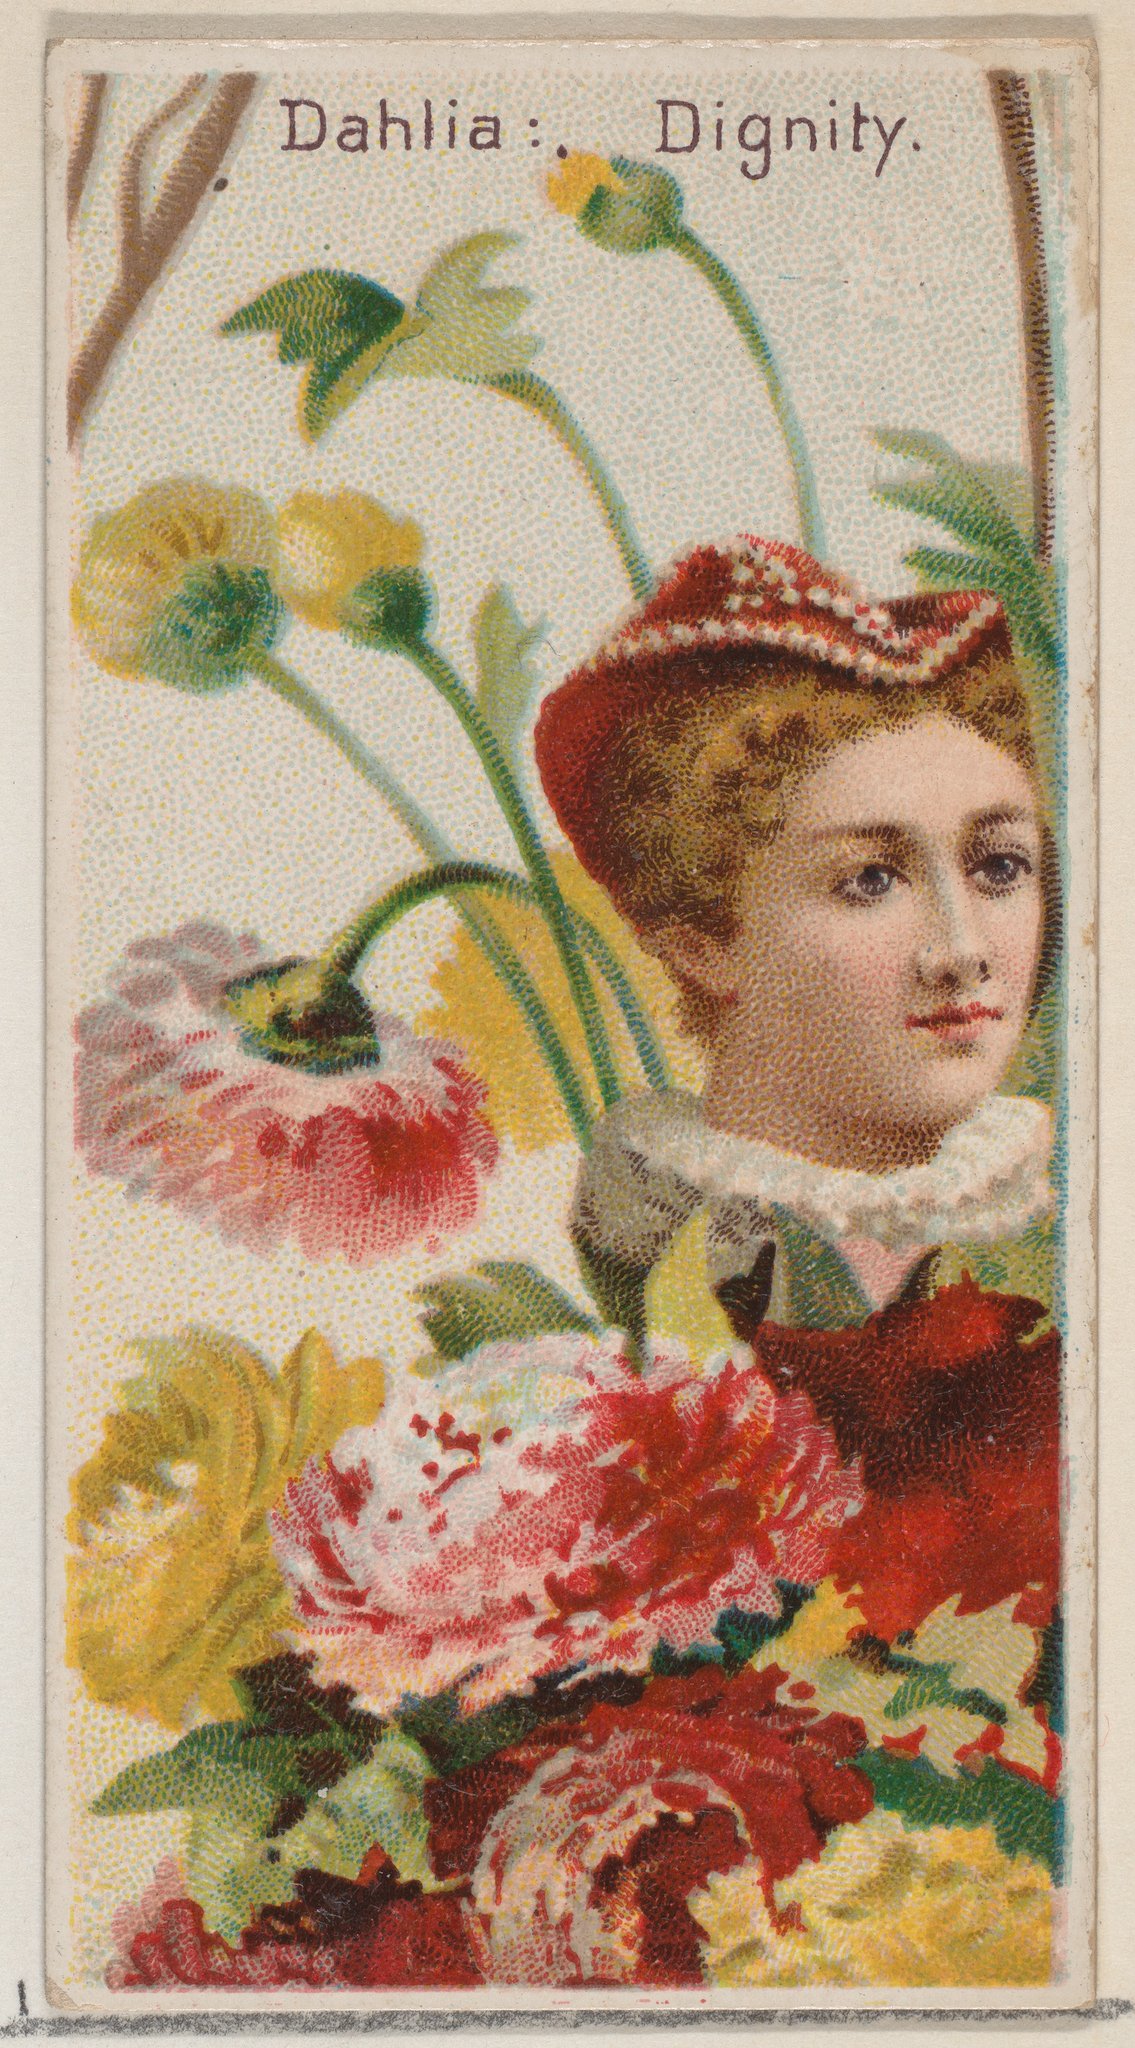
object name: print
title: Dahlia: Dignity, from the series Floral Beauties and Language of Flowers (N75) for Duke brand cigarettes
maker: american tobacco company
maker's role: publisher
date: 1892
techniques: color lithograph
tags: women,flowers